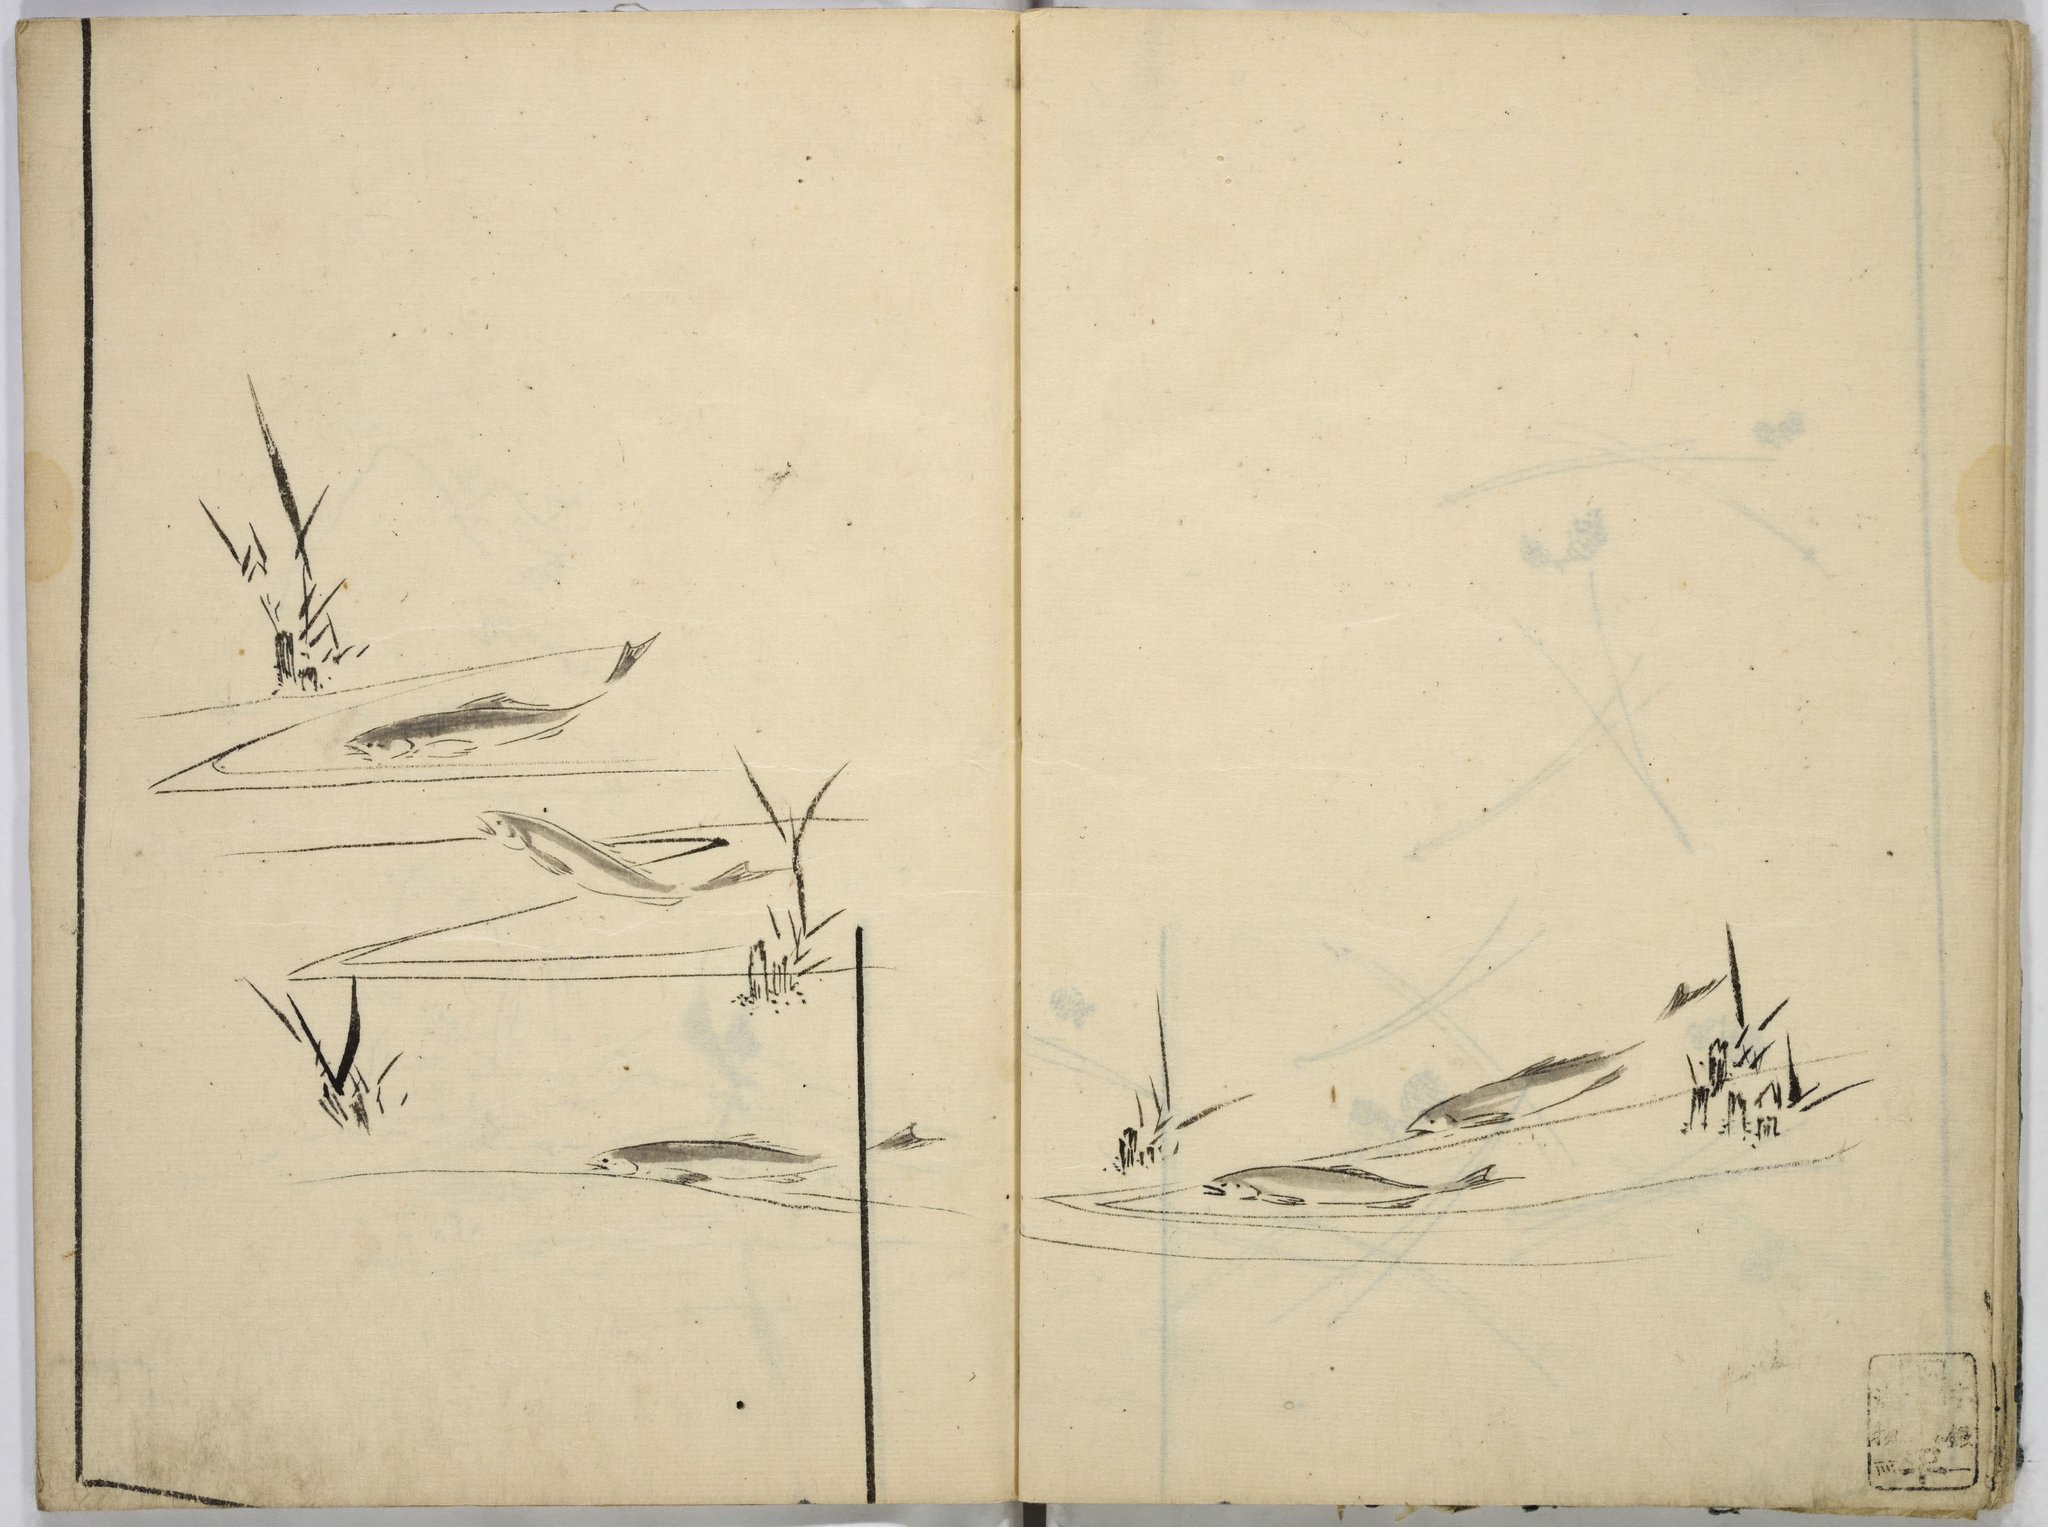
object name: illustrated book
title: Book of Kimono Patterns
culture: japanese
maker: unidentified artist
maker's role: artist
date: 1615-1868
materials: ink, paper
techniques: drawing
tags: fish